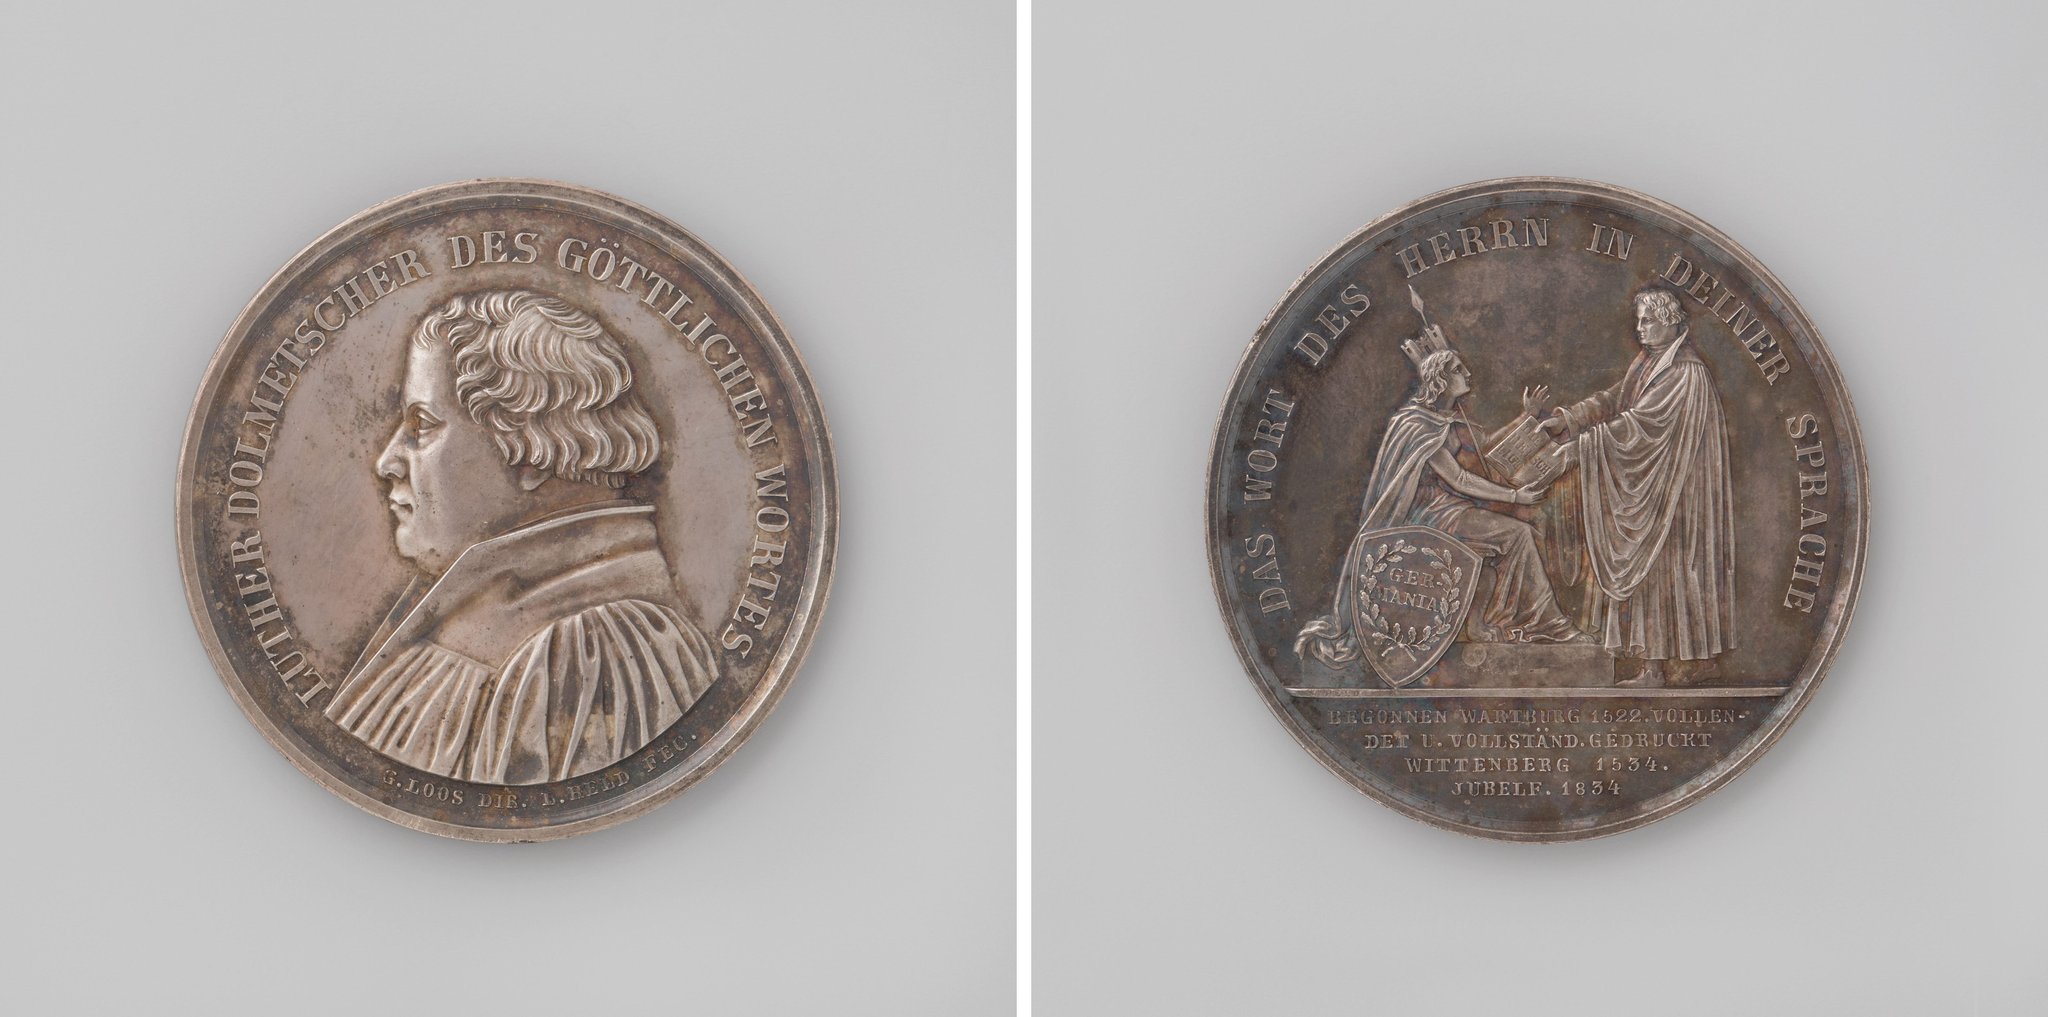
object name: history medal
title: Derde eeuwfeest op de vertaling van de Bijbel door Martin Luther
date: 1834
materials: silver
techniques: striking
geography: berlin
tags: priest, martin luther, the bible as a book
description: Zilveren penning. Voorzijde: borststuk man binnen omschrift. Keerzijde: Germania, afgebeeld als gekroondevrouw met lans en wapenschild, zit op verhoging en ontvangt van voor haar staande Luther een geopend boek binnen omschrift; afsnede: opschrift